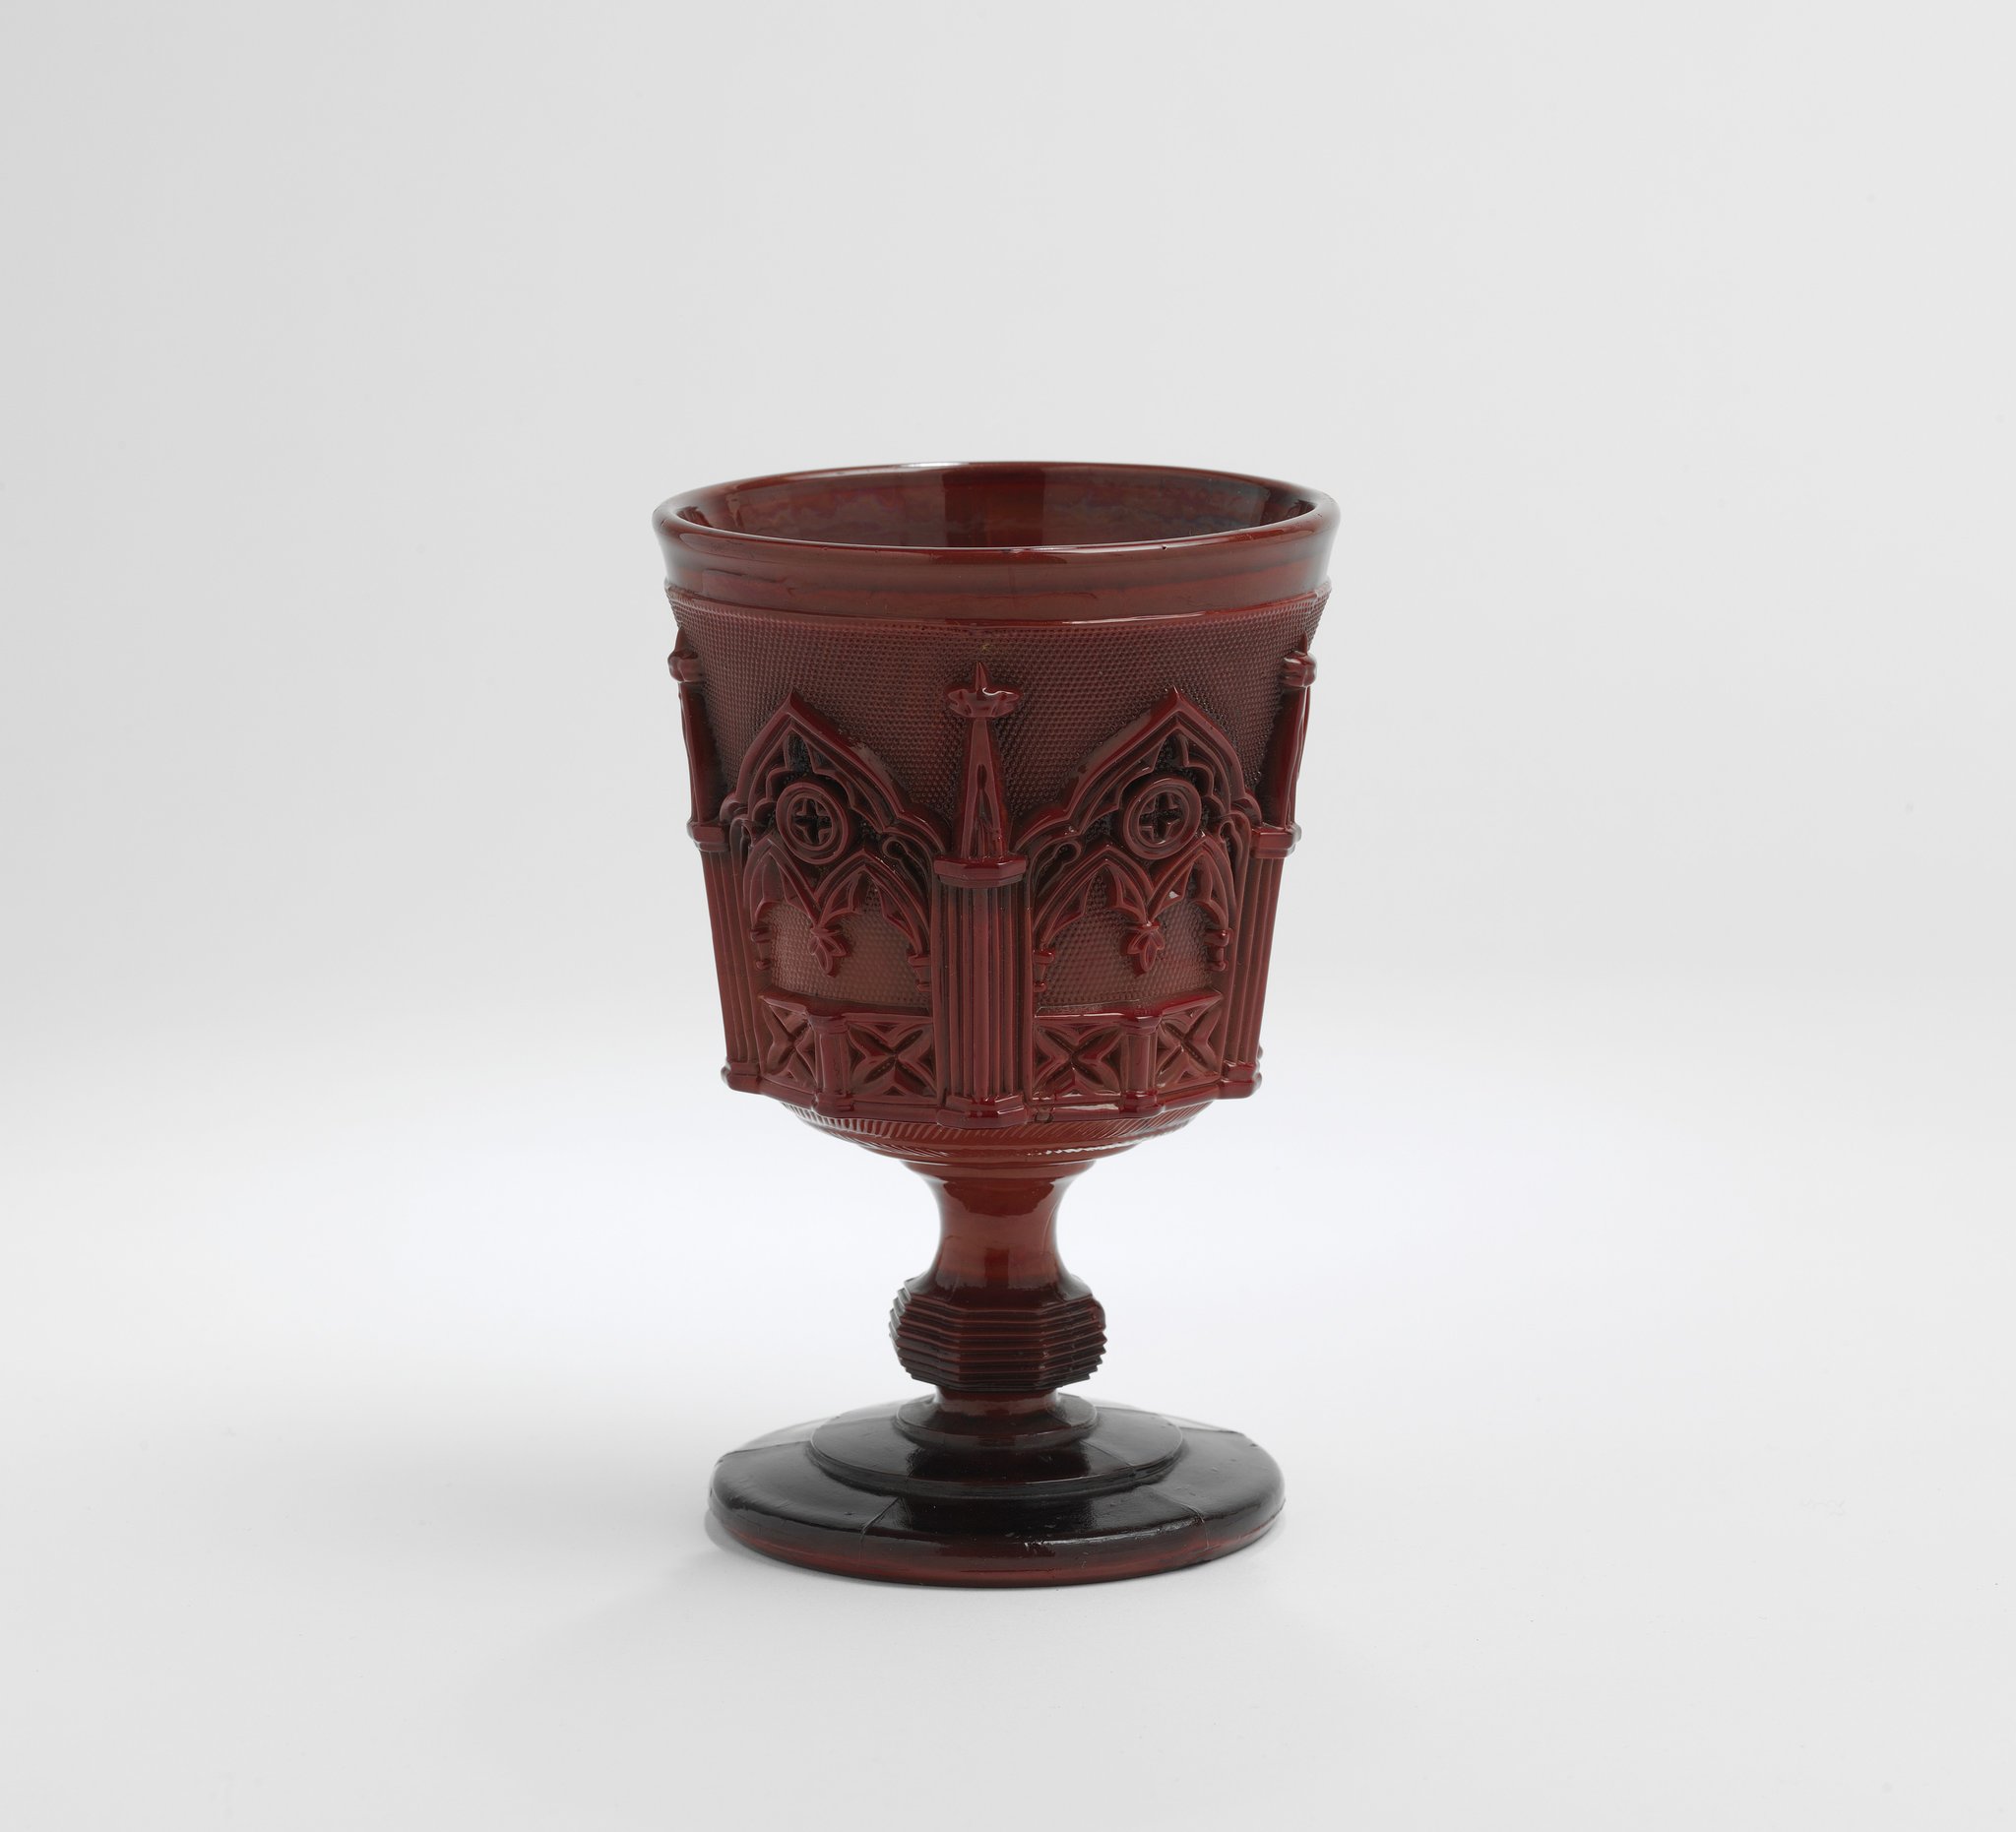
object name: water goblet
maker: compagnie des cristalleries de saint-louis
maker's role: maker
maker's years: 1586-1767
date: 1845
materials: glass